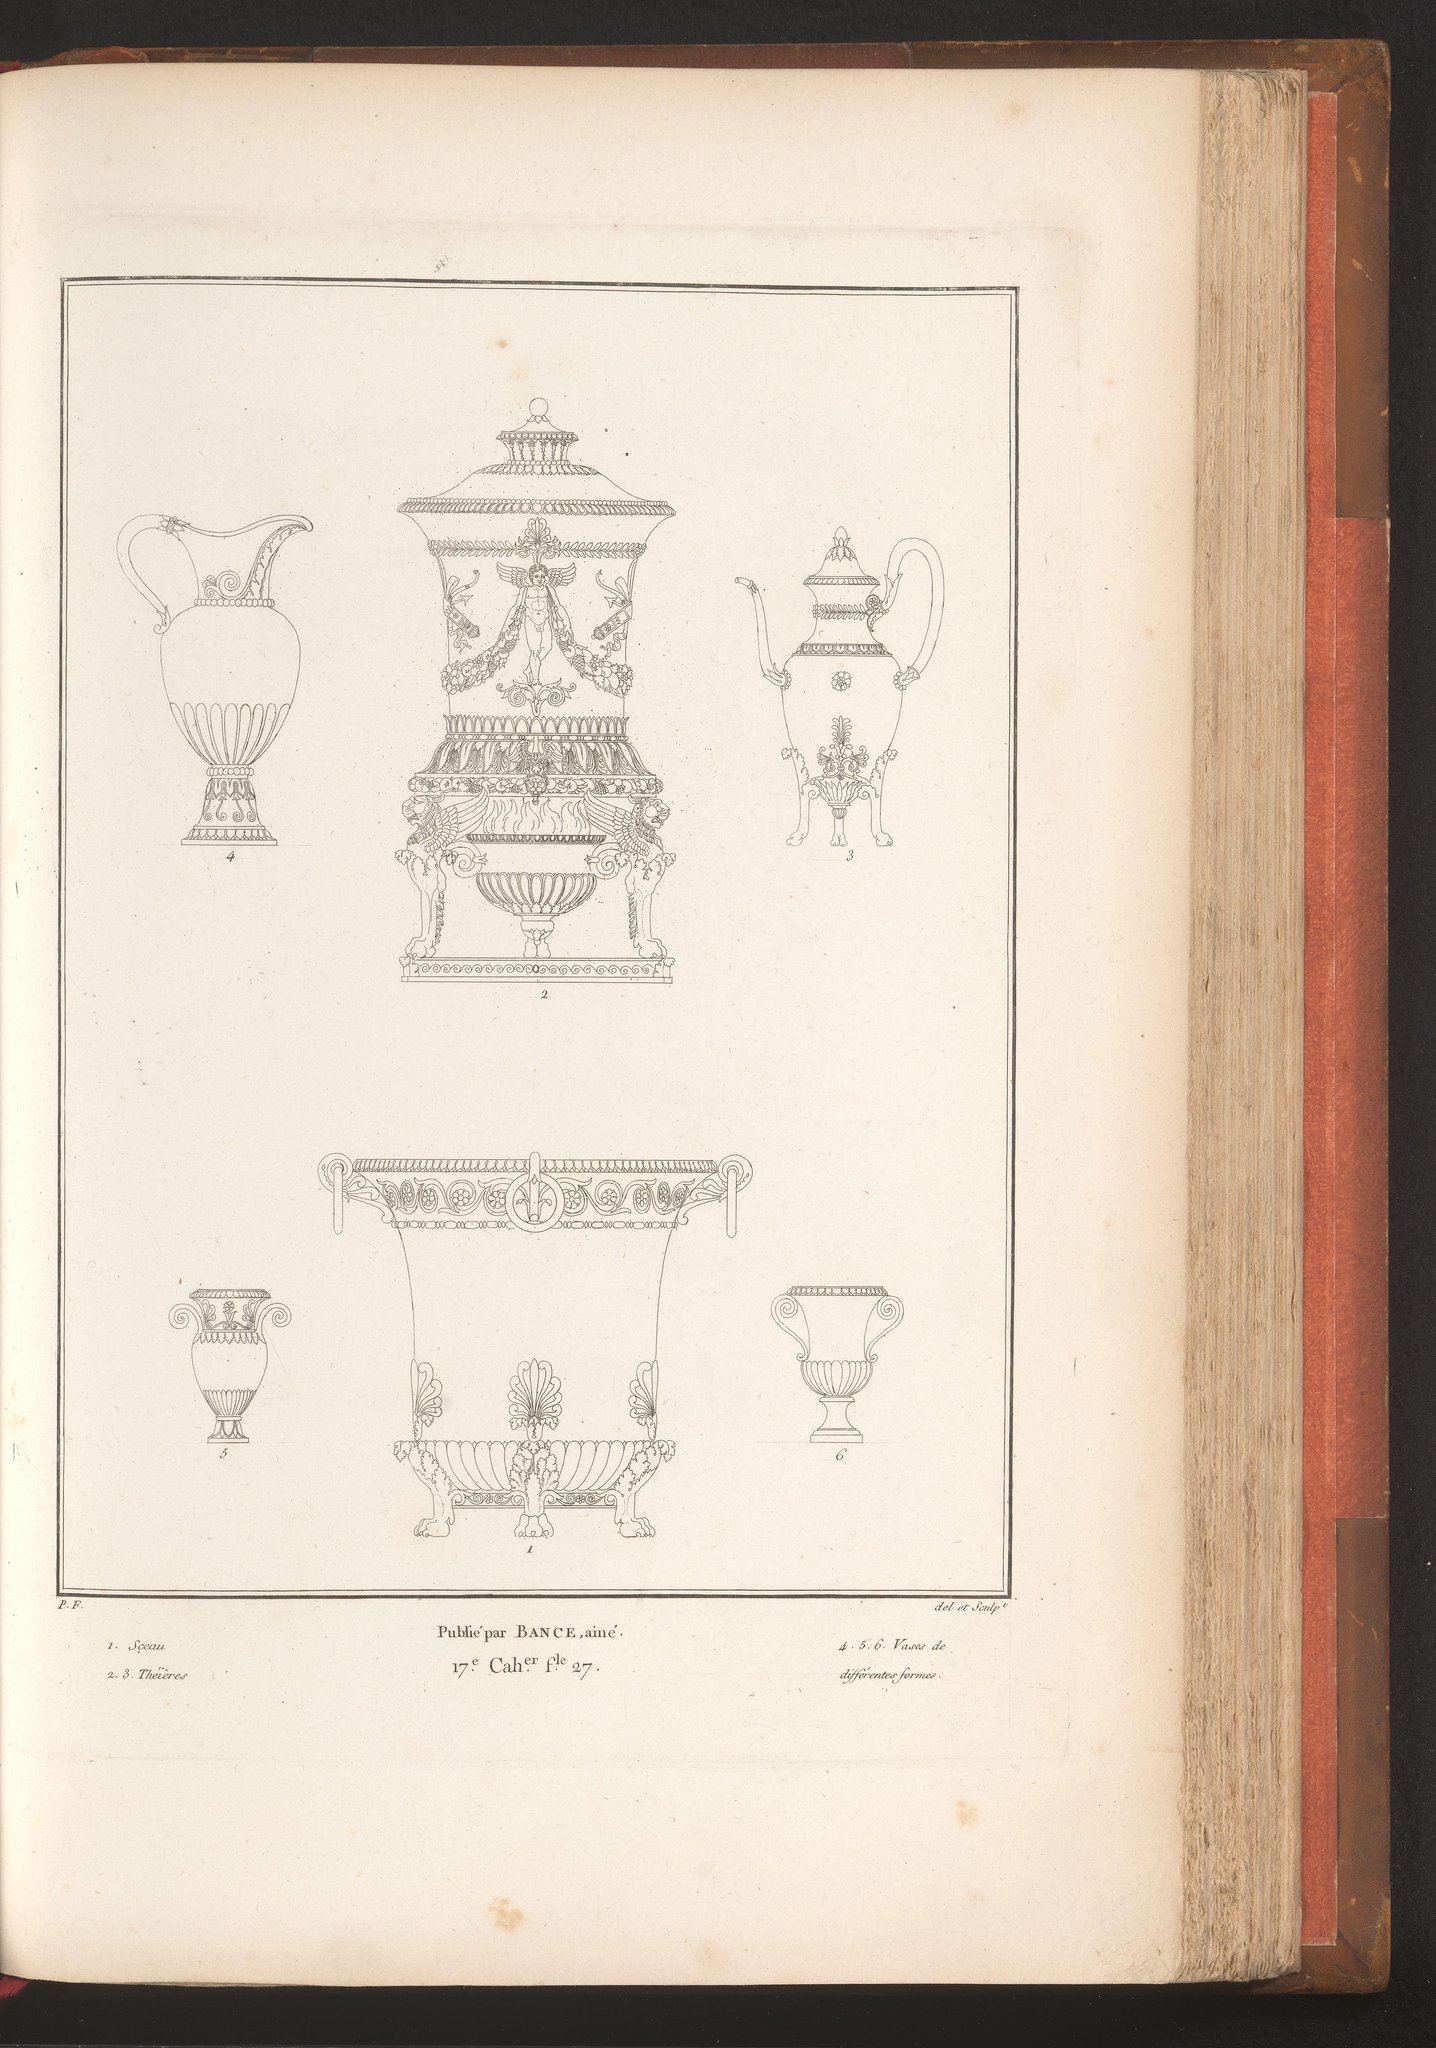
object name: ornament print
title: Diverse vazen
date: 1820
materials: paper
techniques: etching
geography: paris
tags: vase ~ ornament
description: Ornamentprent met zes verschillende vazen en houders. Onderdeel (17e. Cah.er f.le 27) van het prentalbum met twee series van in totaal 138 ornamentprenten door Beauvallet en Normand, 'Fragmens d'Ornemens dans le Style Antique'.